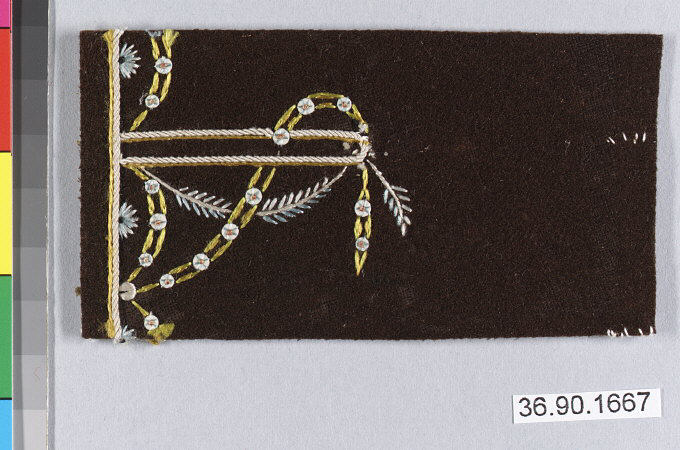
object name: sample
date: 1801-1833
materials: felt, silk